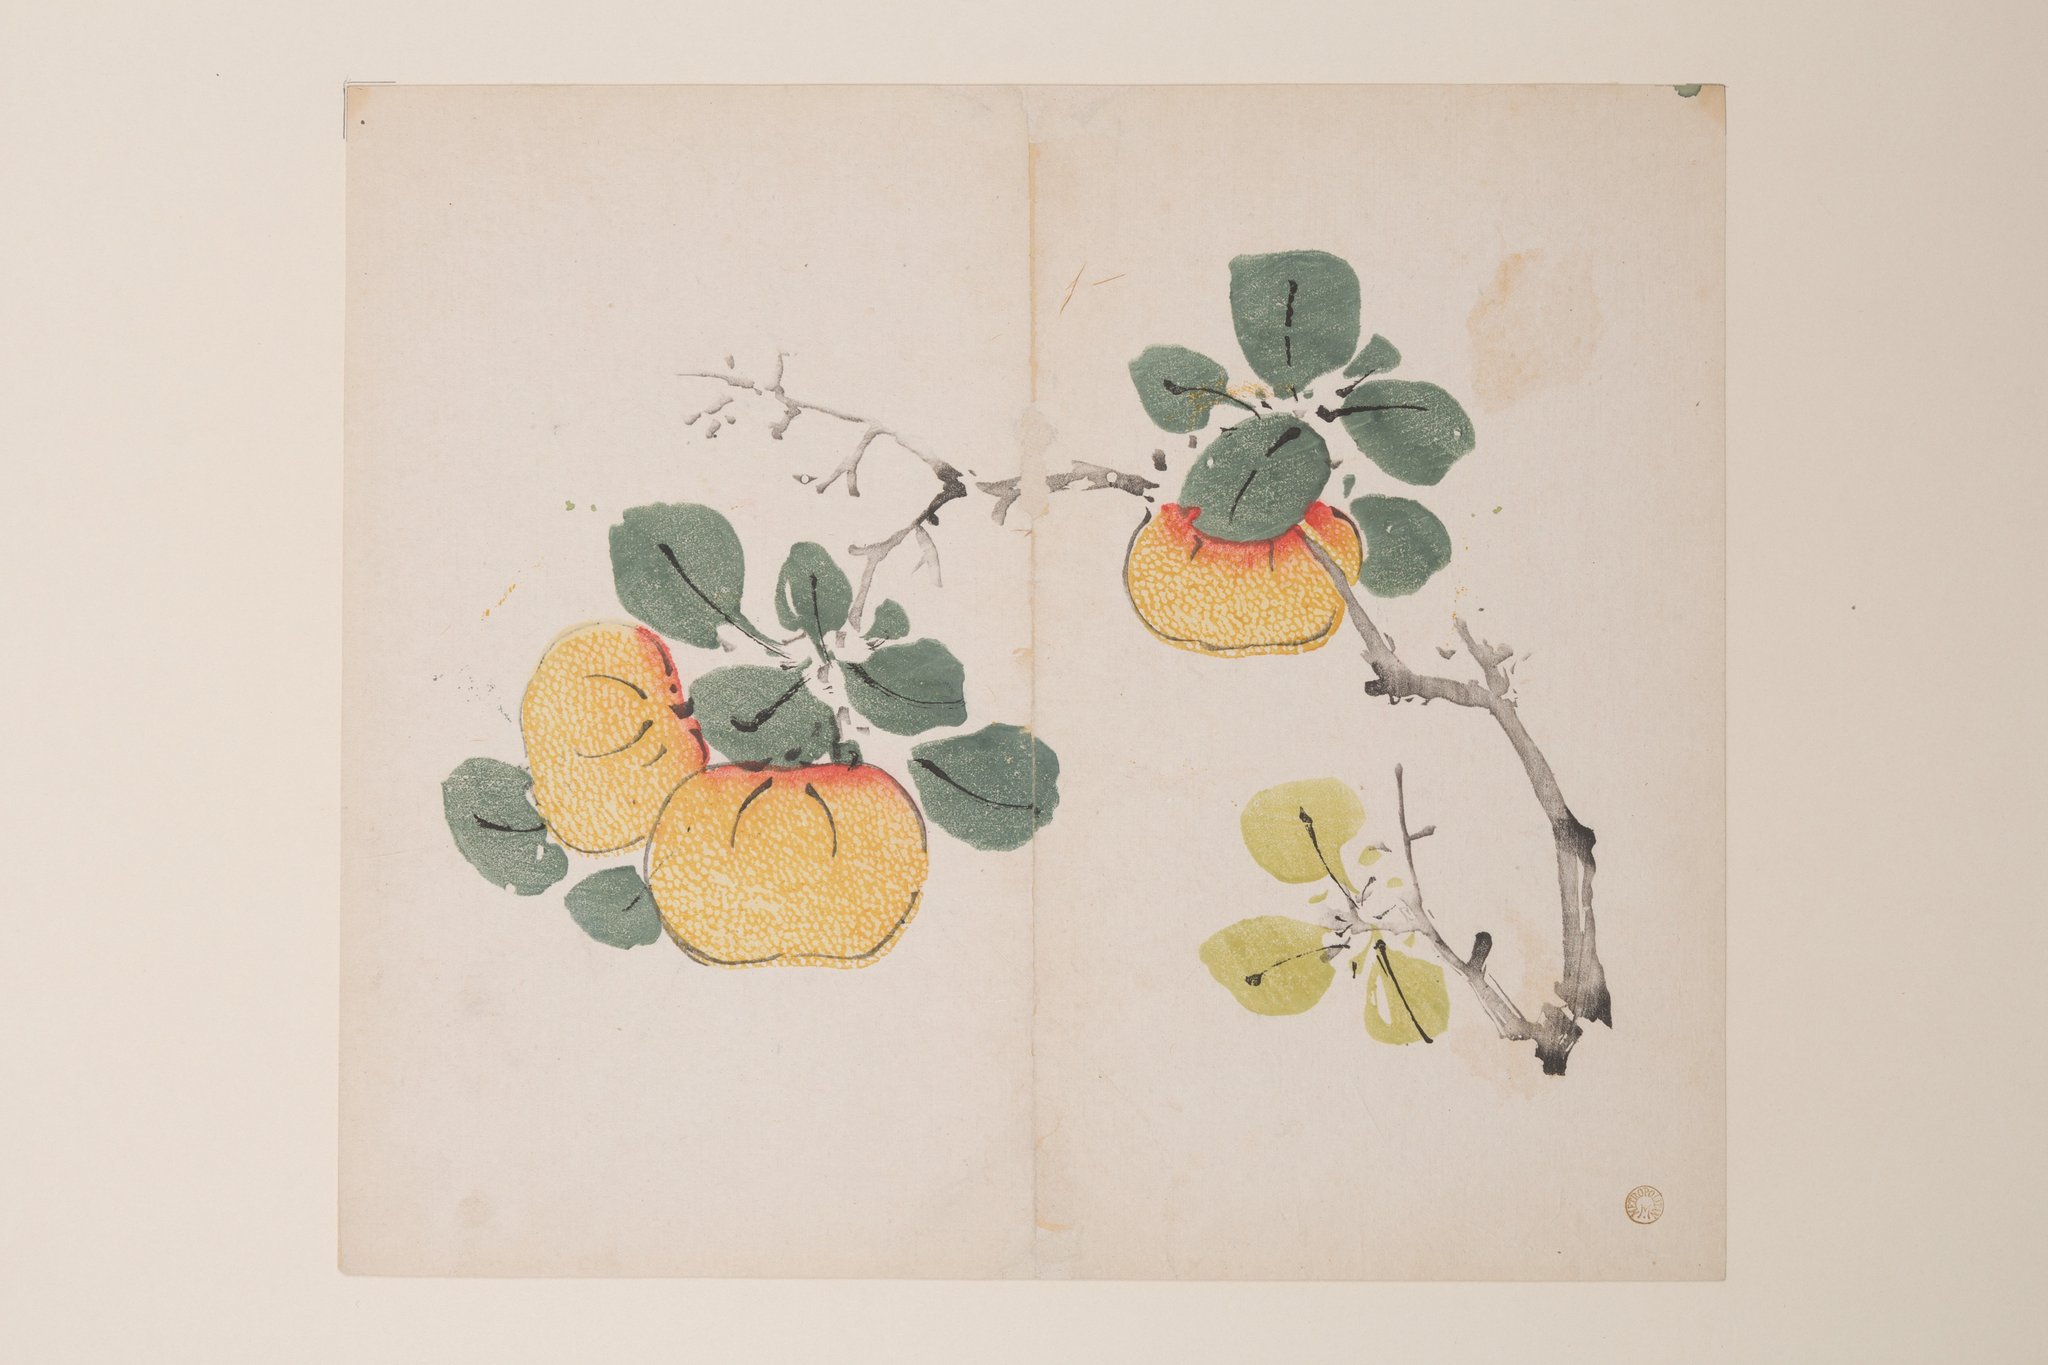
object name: print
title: Page from the Ten Bamboo Studio Manual of Painting and Calligraphy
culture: chinese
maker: hu zhengyan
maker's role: artist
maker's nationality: chinese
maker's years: 1584-1634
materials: ink, paper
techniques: printing